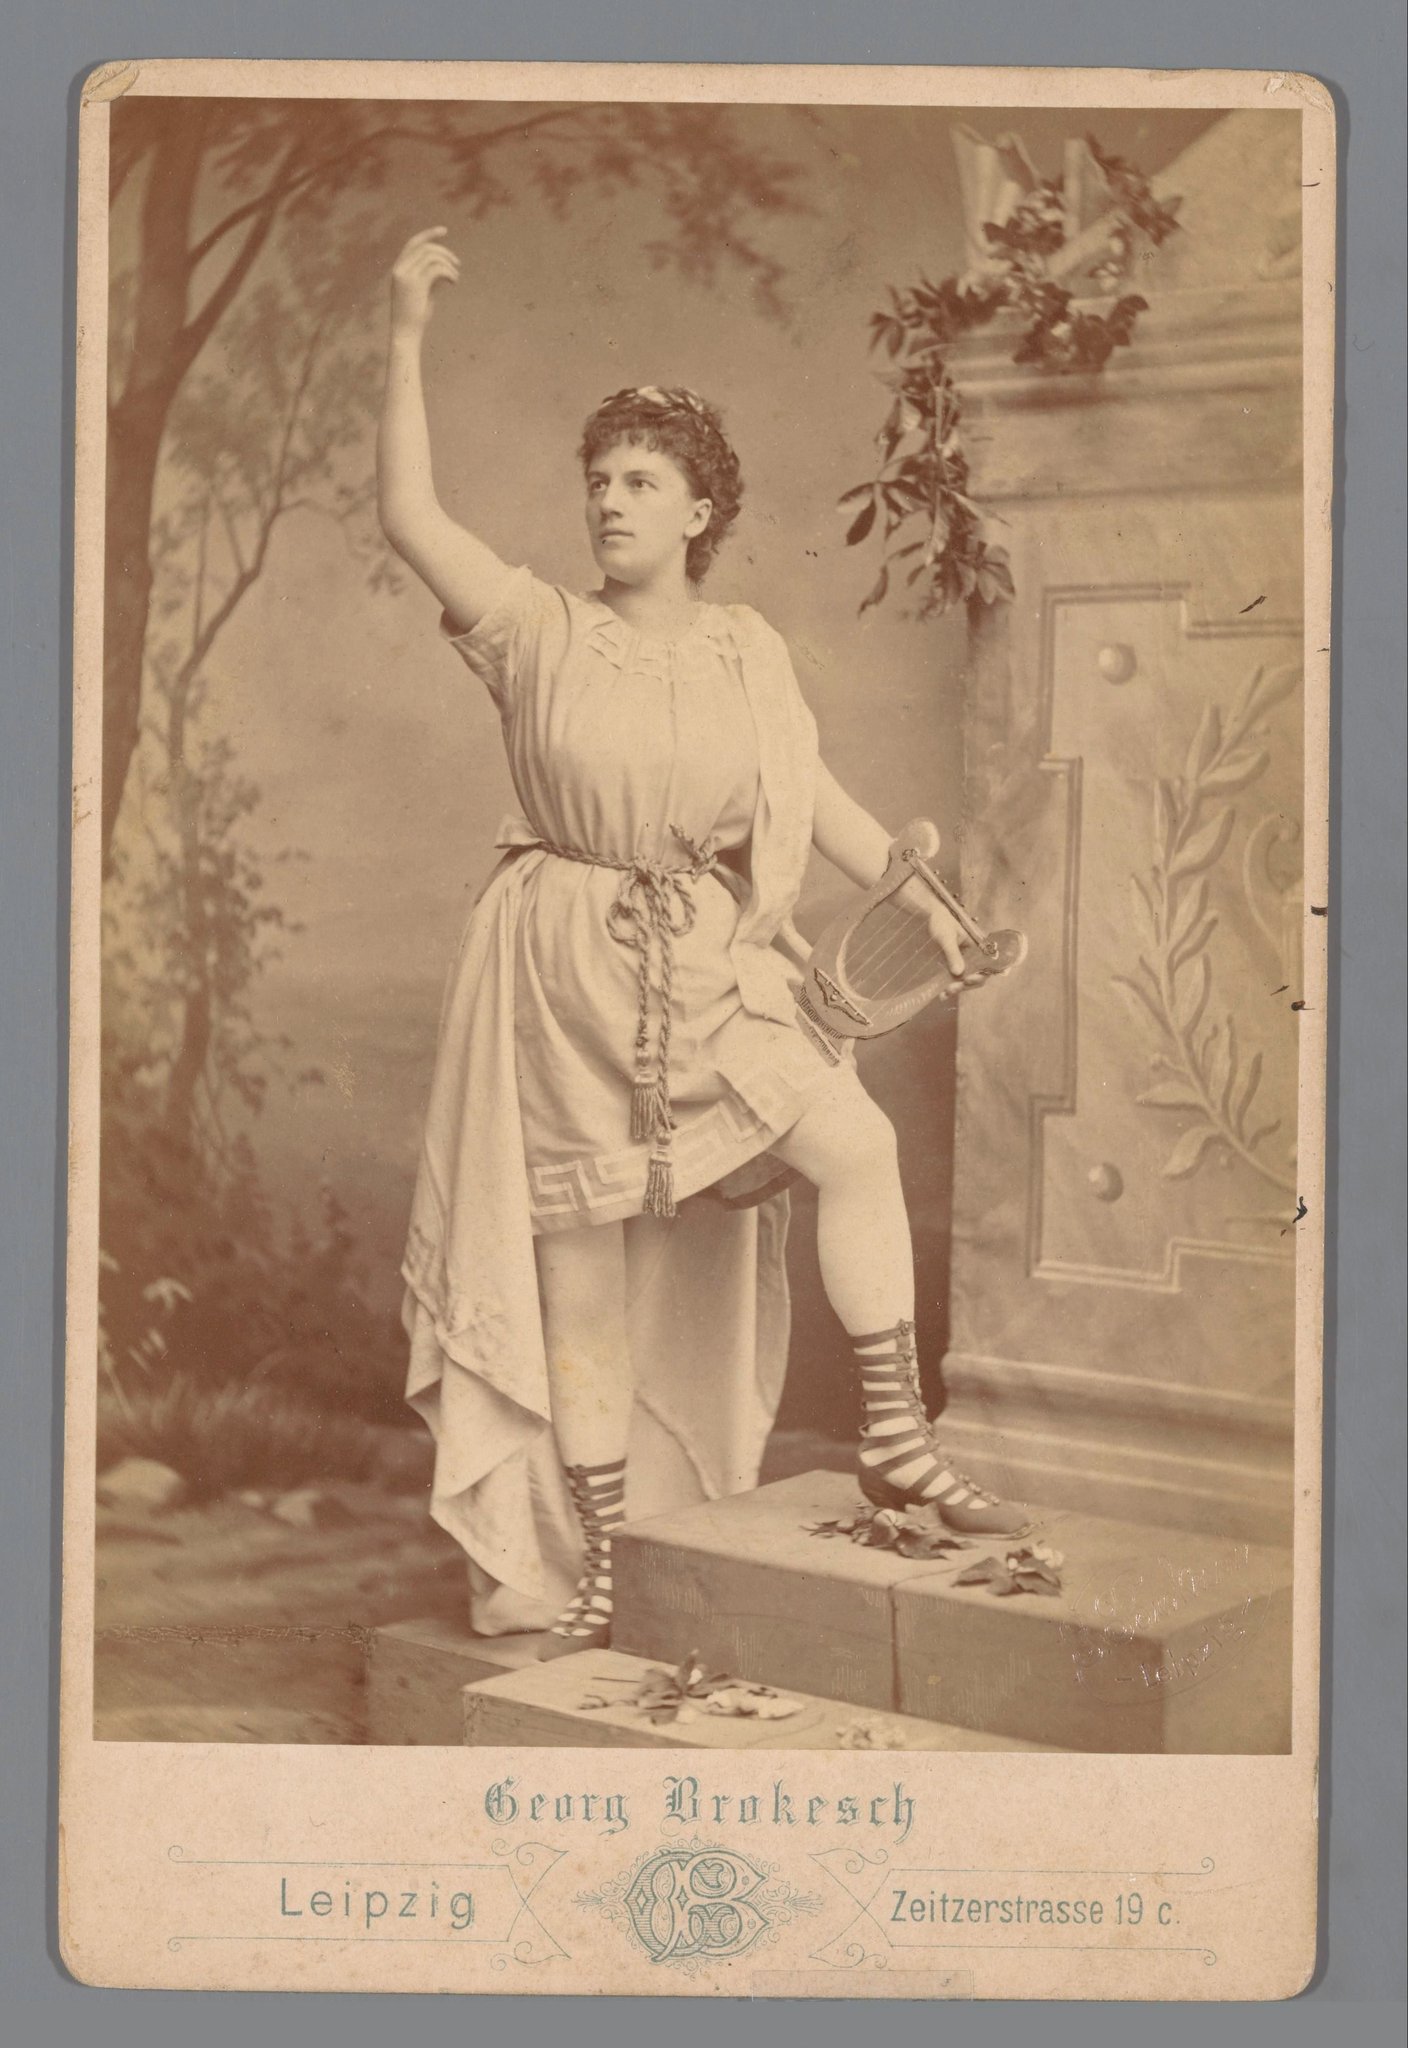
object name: photograph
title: Portret van een actrice in kostuum met harp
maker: georg brokesch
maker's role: fotograaf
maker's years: 1849-1896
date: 1879-1900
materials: cardboard, photographic support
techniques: albumen print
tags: portrait of actor, actress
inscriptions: : ‘Prämurt 1879 / Leipzig I. Preis / Dresden I. Preis’, : ‘Leipzig, Zeitzerstrasse 19c’